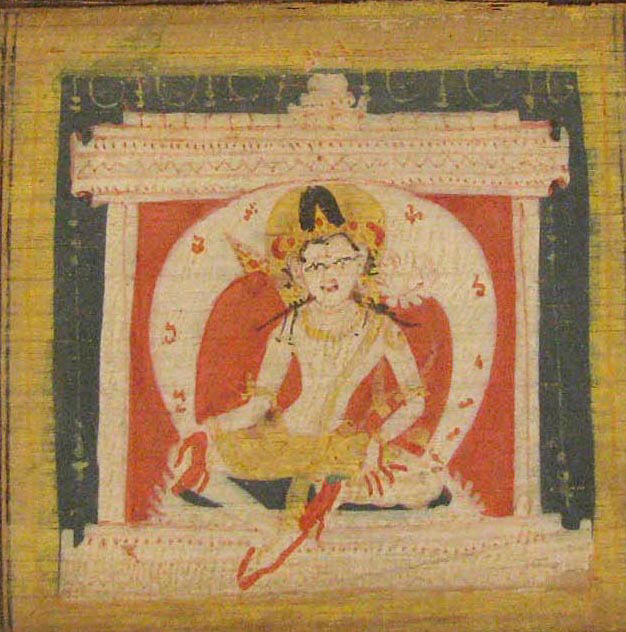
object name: folio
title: Folio from a Buddhist Manuscript of Pancavimsatisahasrika Prajnaparamita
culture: indian, bengal or bangladesh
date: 1090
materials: leaf, watercolor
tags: buddhism